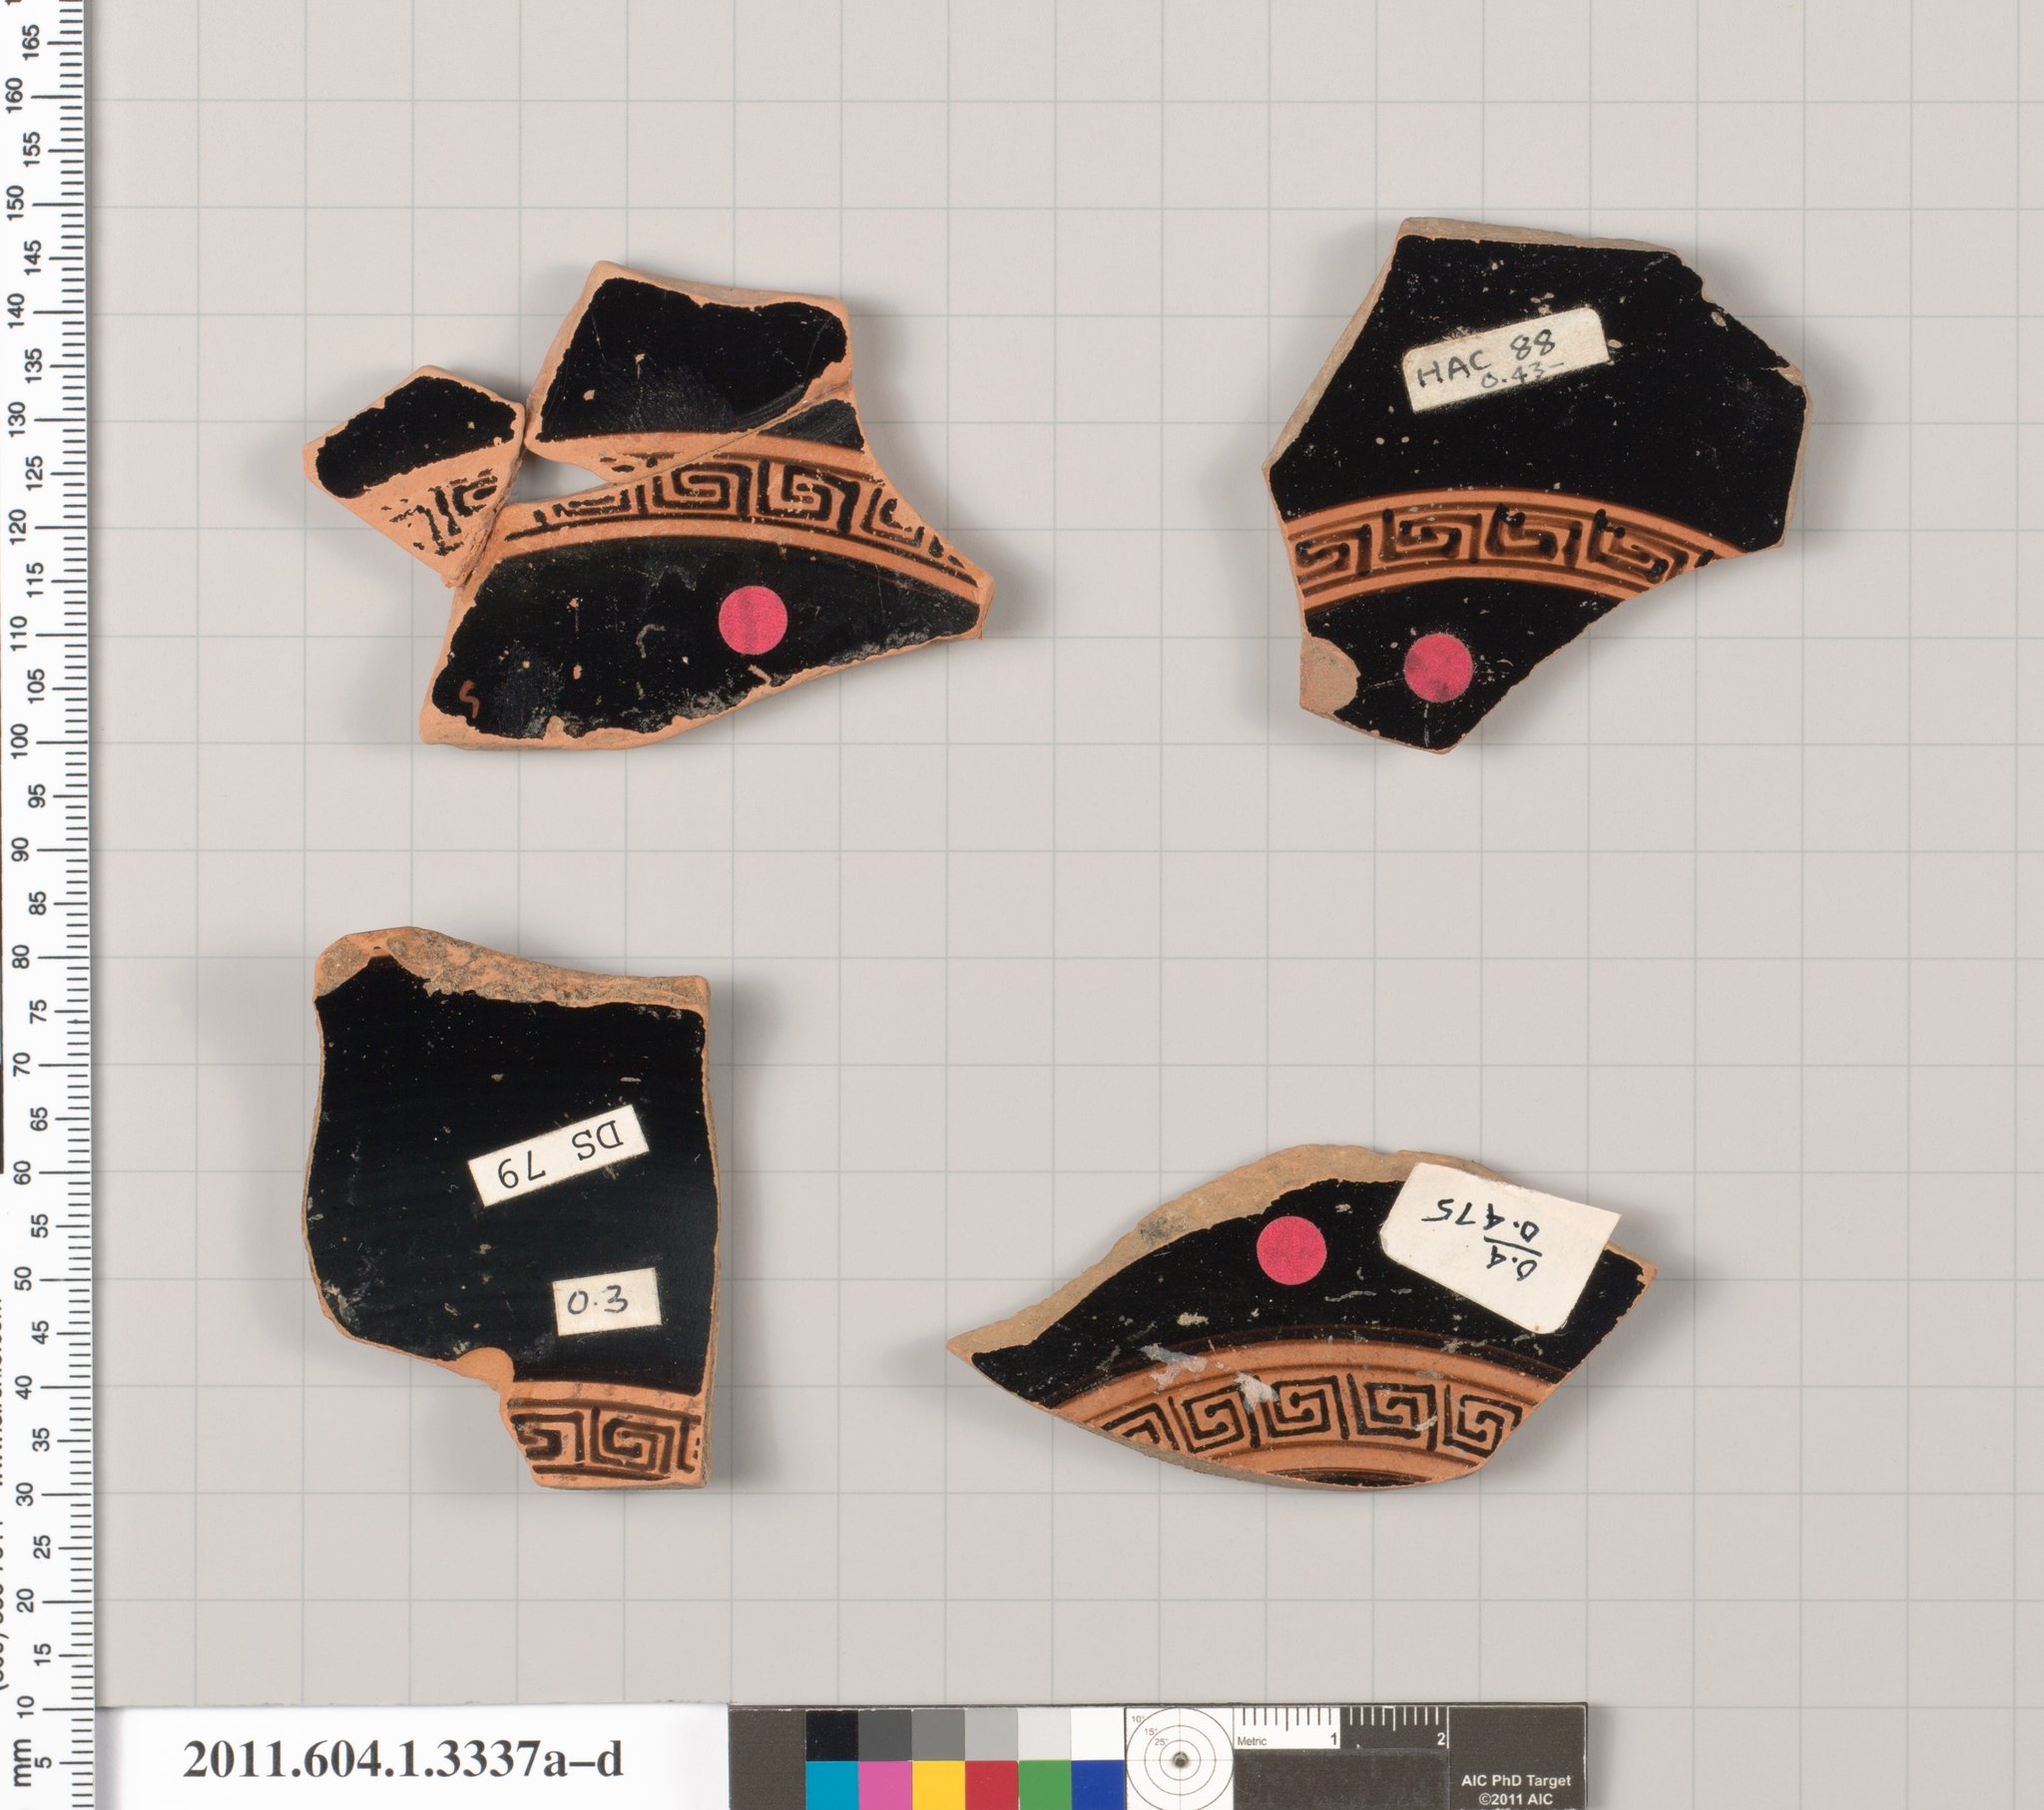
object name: kylix fragment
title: Terracotta fragments of kylikes (drinking cups)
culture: greek, attic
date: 500-470 BCE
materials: terracotta